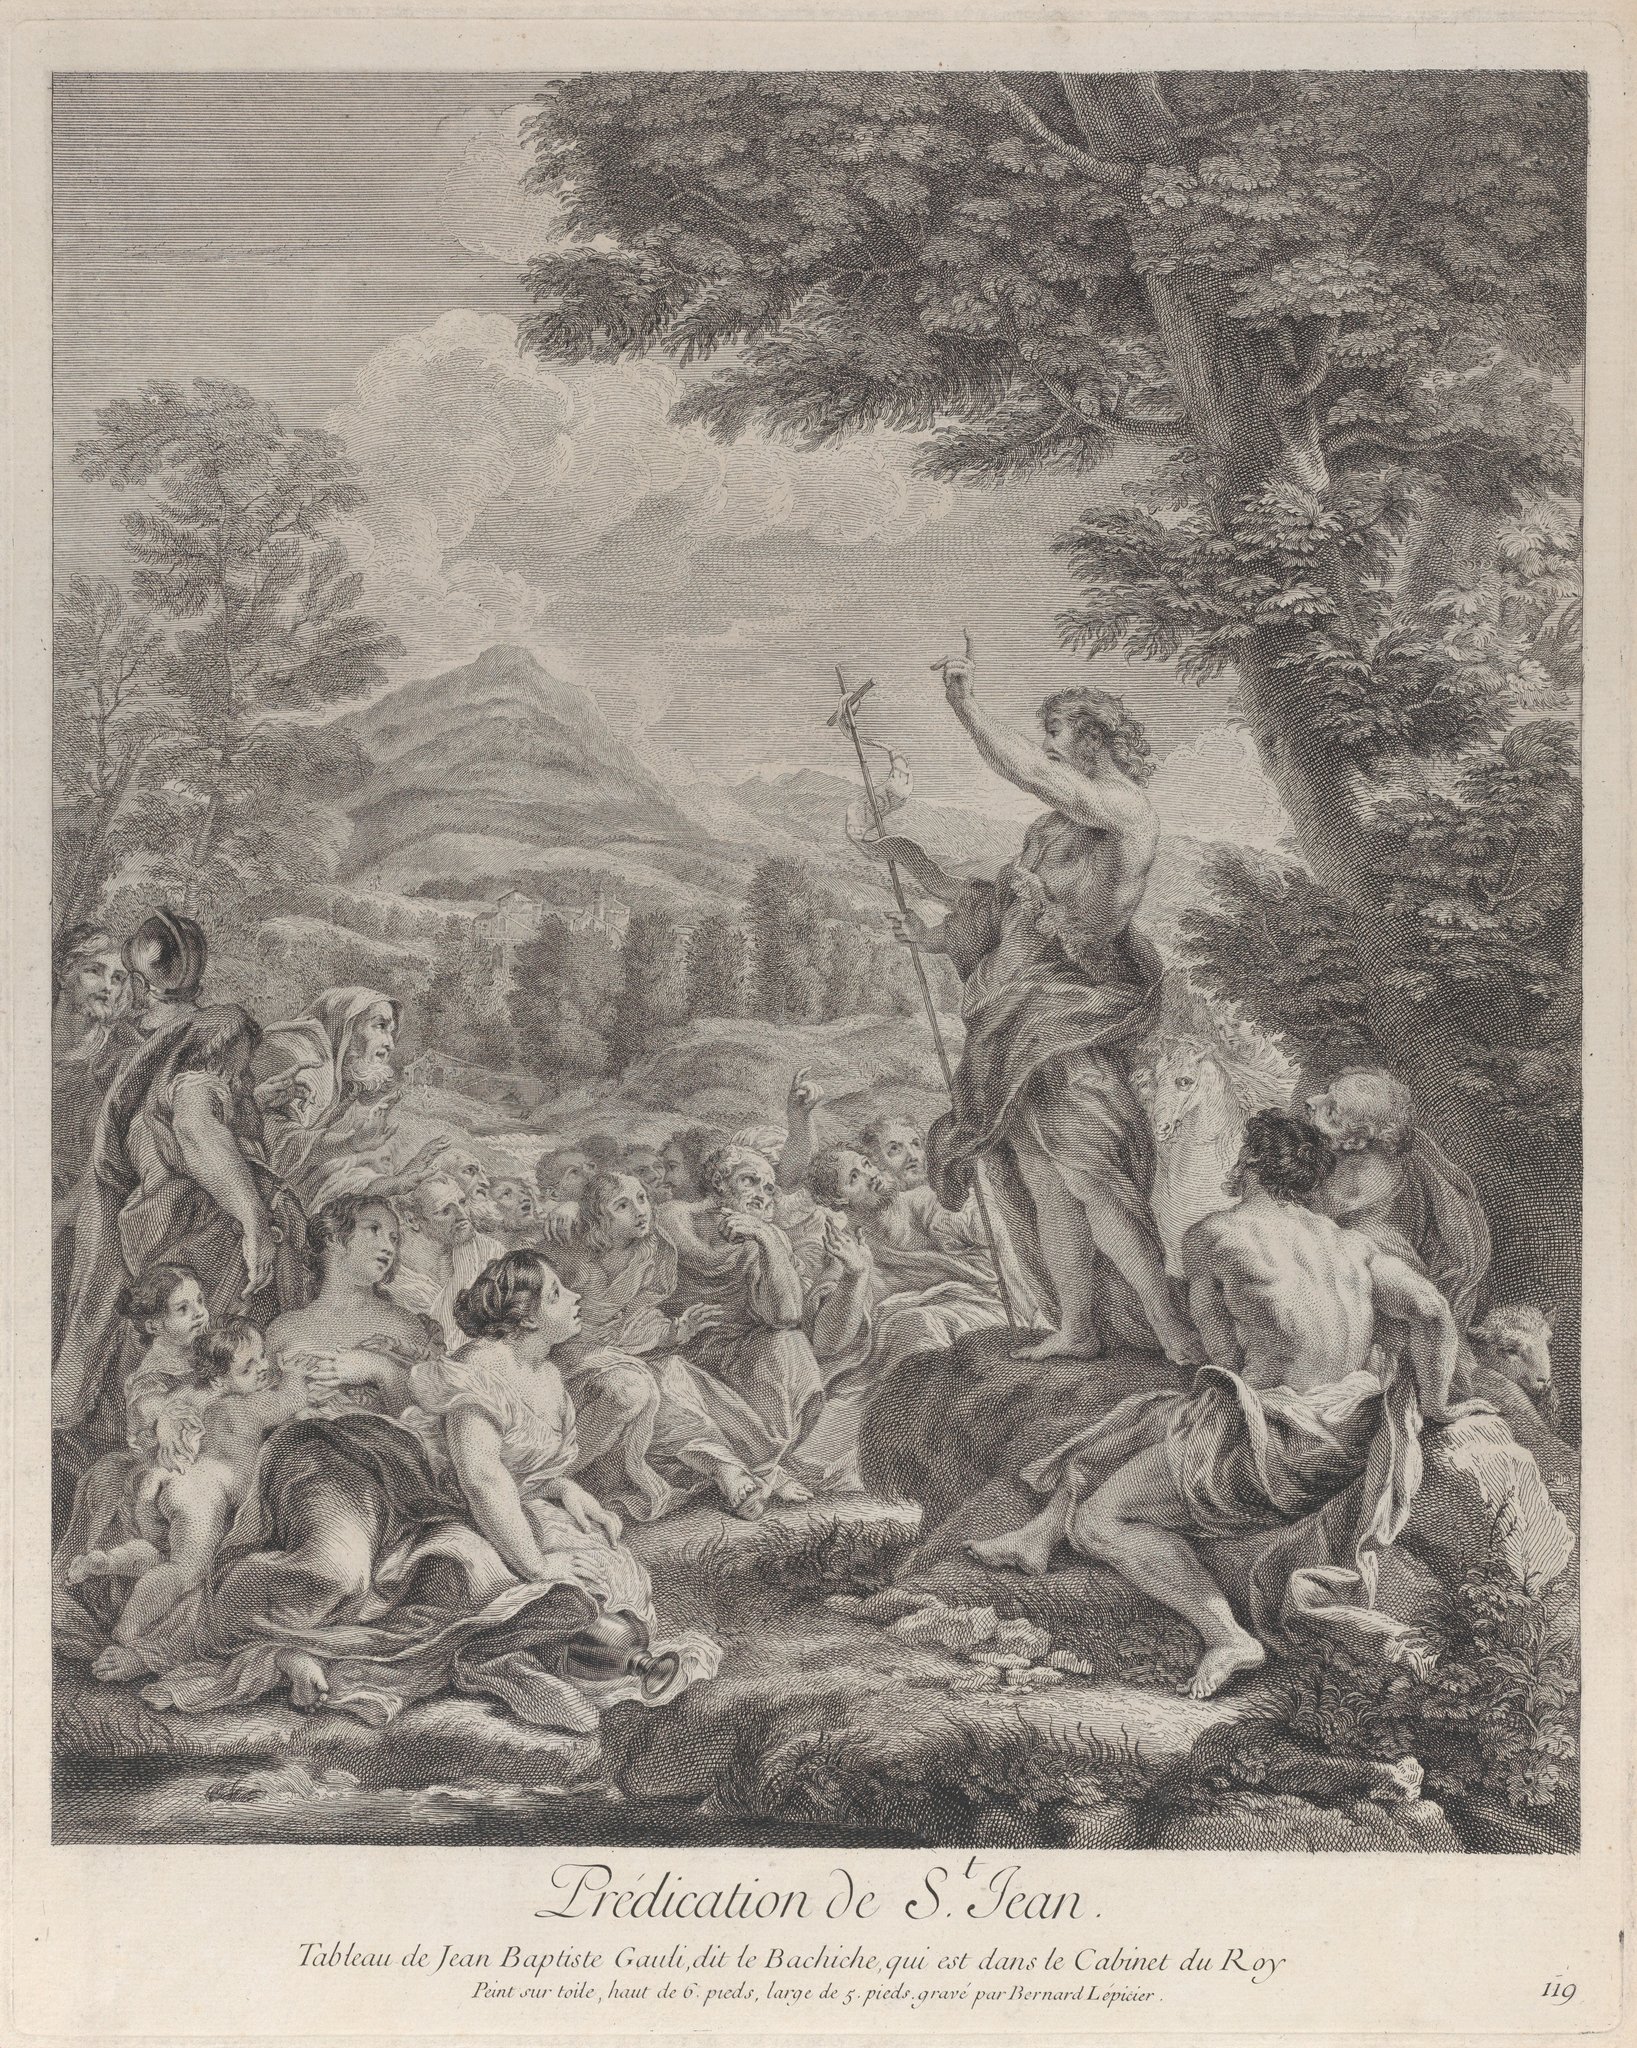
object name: print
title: Saint John the Baptist preaching to a crowd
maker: bernard lepicié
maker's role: artist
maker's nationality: french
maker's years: 1698-1755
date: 1729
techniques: engraving, etching